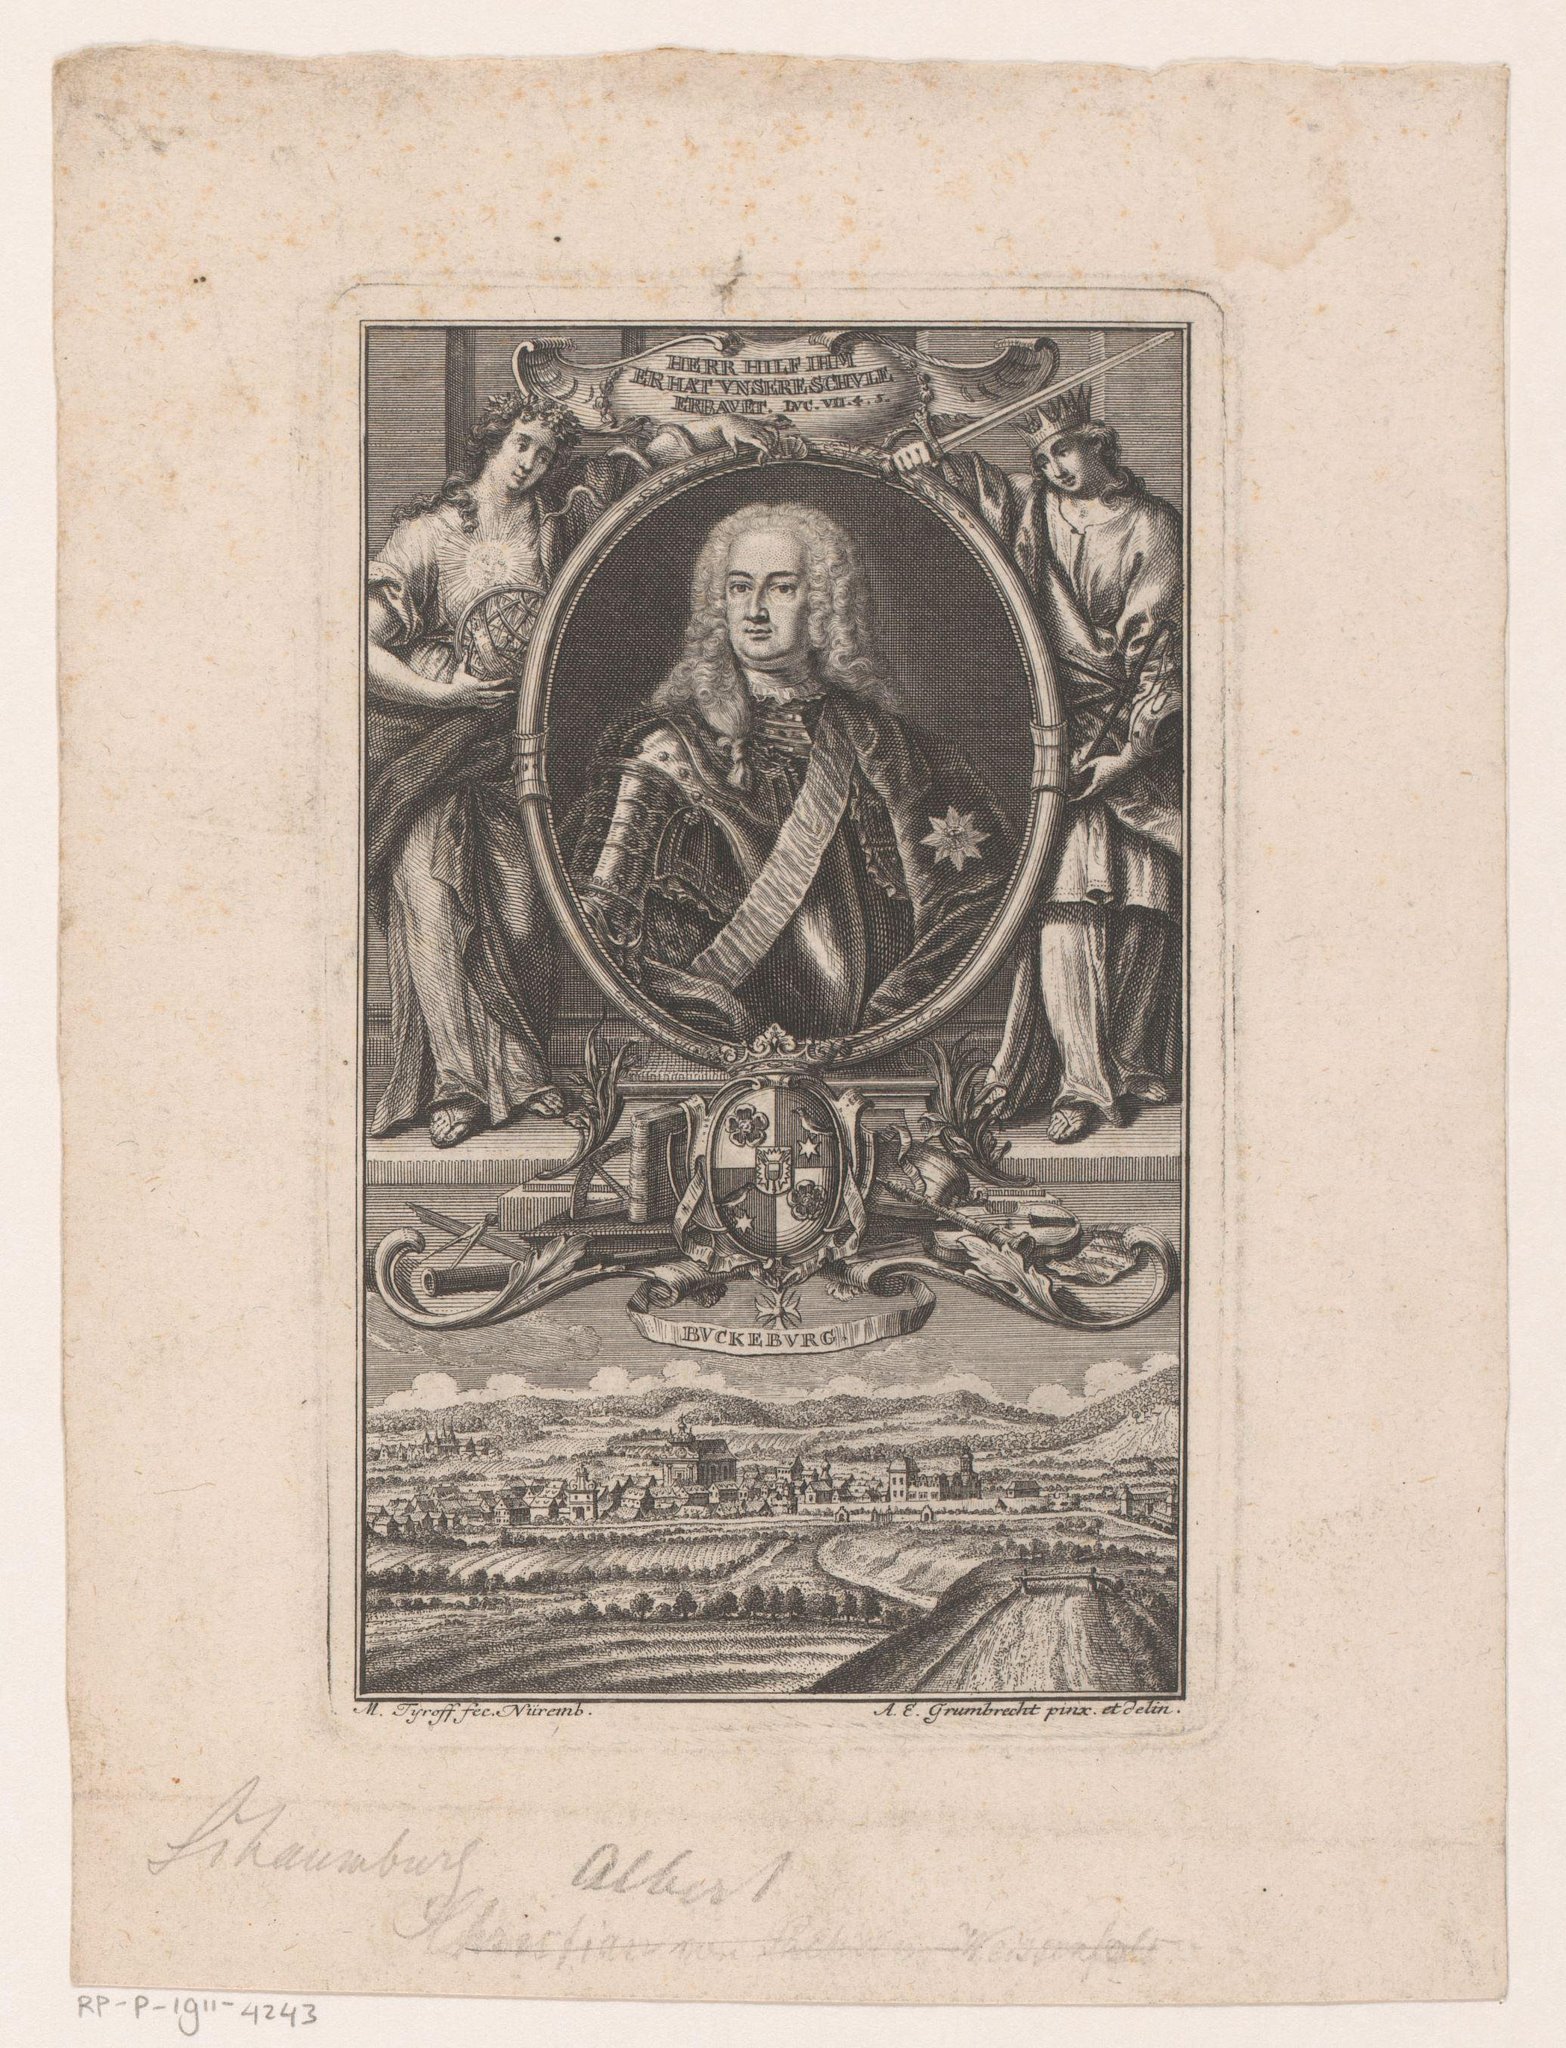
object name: print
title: Portret van Albrecht Wolfgang Graf zu Schaumburg-Lippe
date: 1735-1779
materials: paper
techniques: engraving, etching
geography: nuremberg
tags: musical instruments; group of musical instruments, city-view in general; 'veduta', armour, historical persons, measuring-instruments, justitia (justice) as roman personification, armorial bearing, heraldry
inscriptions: collector's mark: Lugt 2228